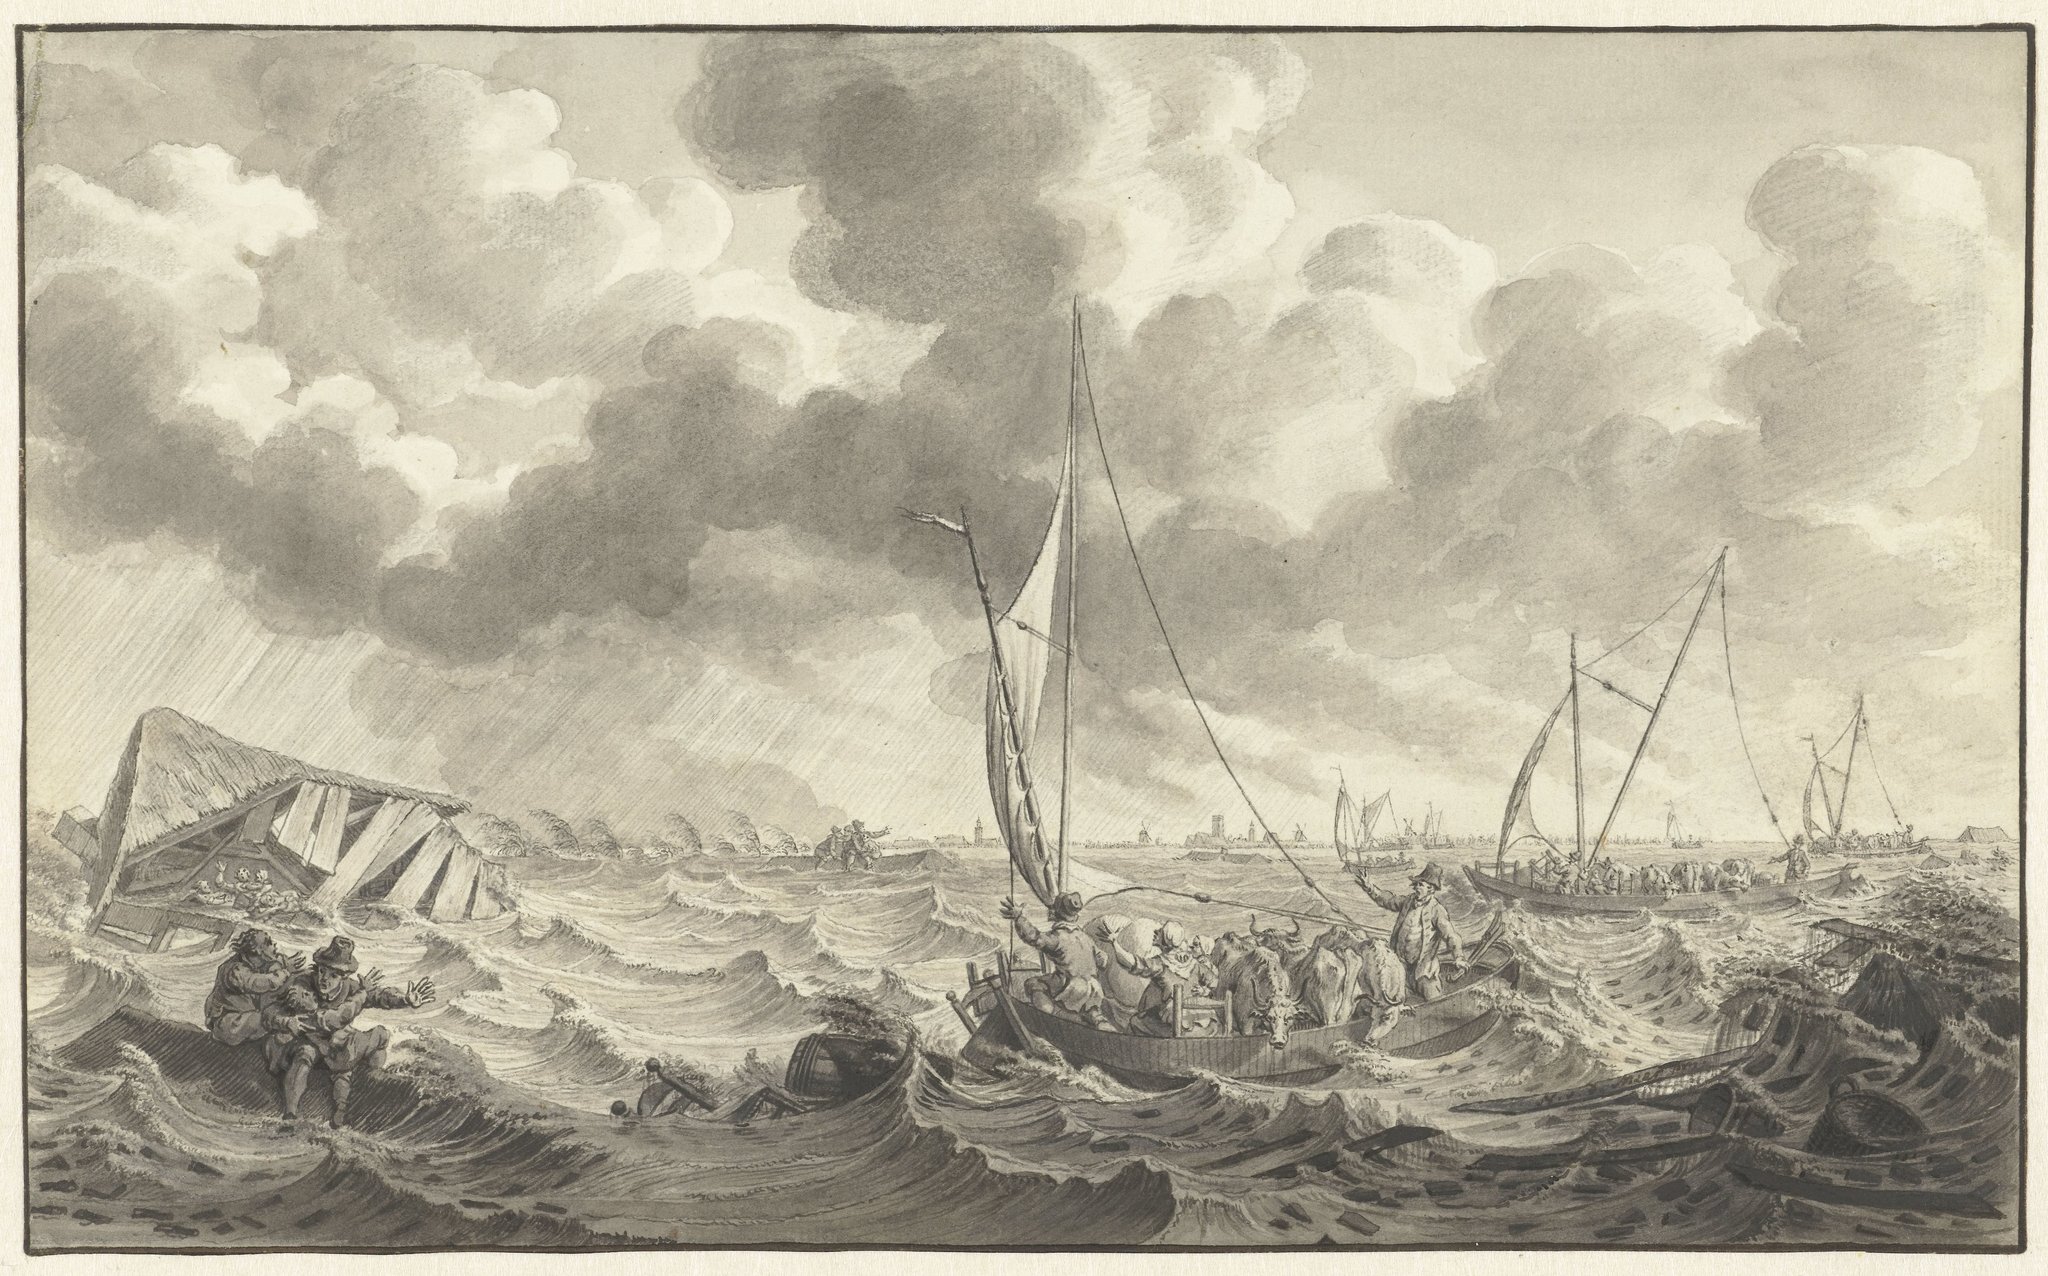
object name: drawing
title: Dijkdoorbraak bij Kampen, 1775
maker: noach van der meer (ii)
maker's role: draughtsman, print maker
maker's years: 1741-1822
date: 1775-1776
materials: paper, pencil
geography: northern netherlands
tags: dike-break, flood, historical events and situations, the flood of 14-18 november 1775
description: Ontwerptekening voor de illustratie in: J.H. Hering, Bespiegeling over Neêrlandsch waternood, tusschen den 14den. en 15den. nov: MDCCLXXV. 2 dln. Amsterdam: wed. Loveringh en Allart, 1776.